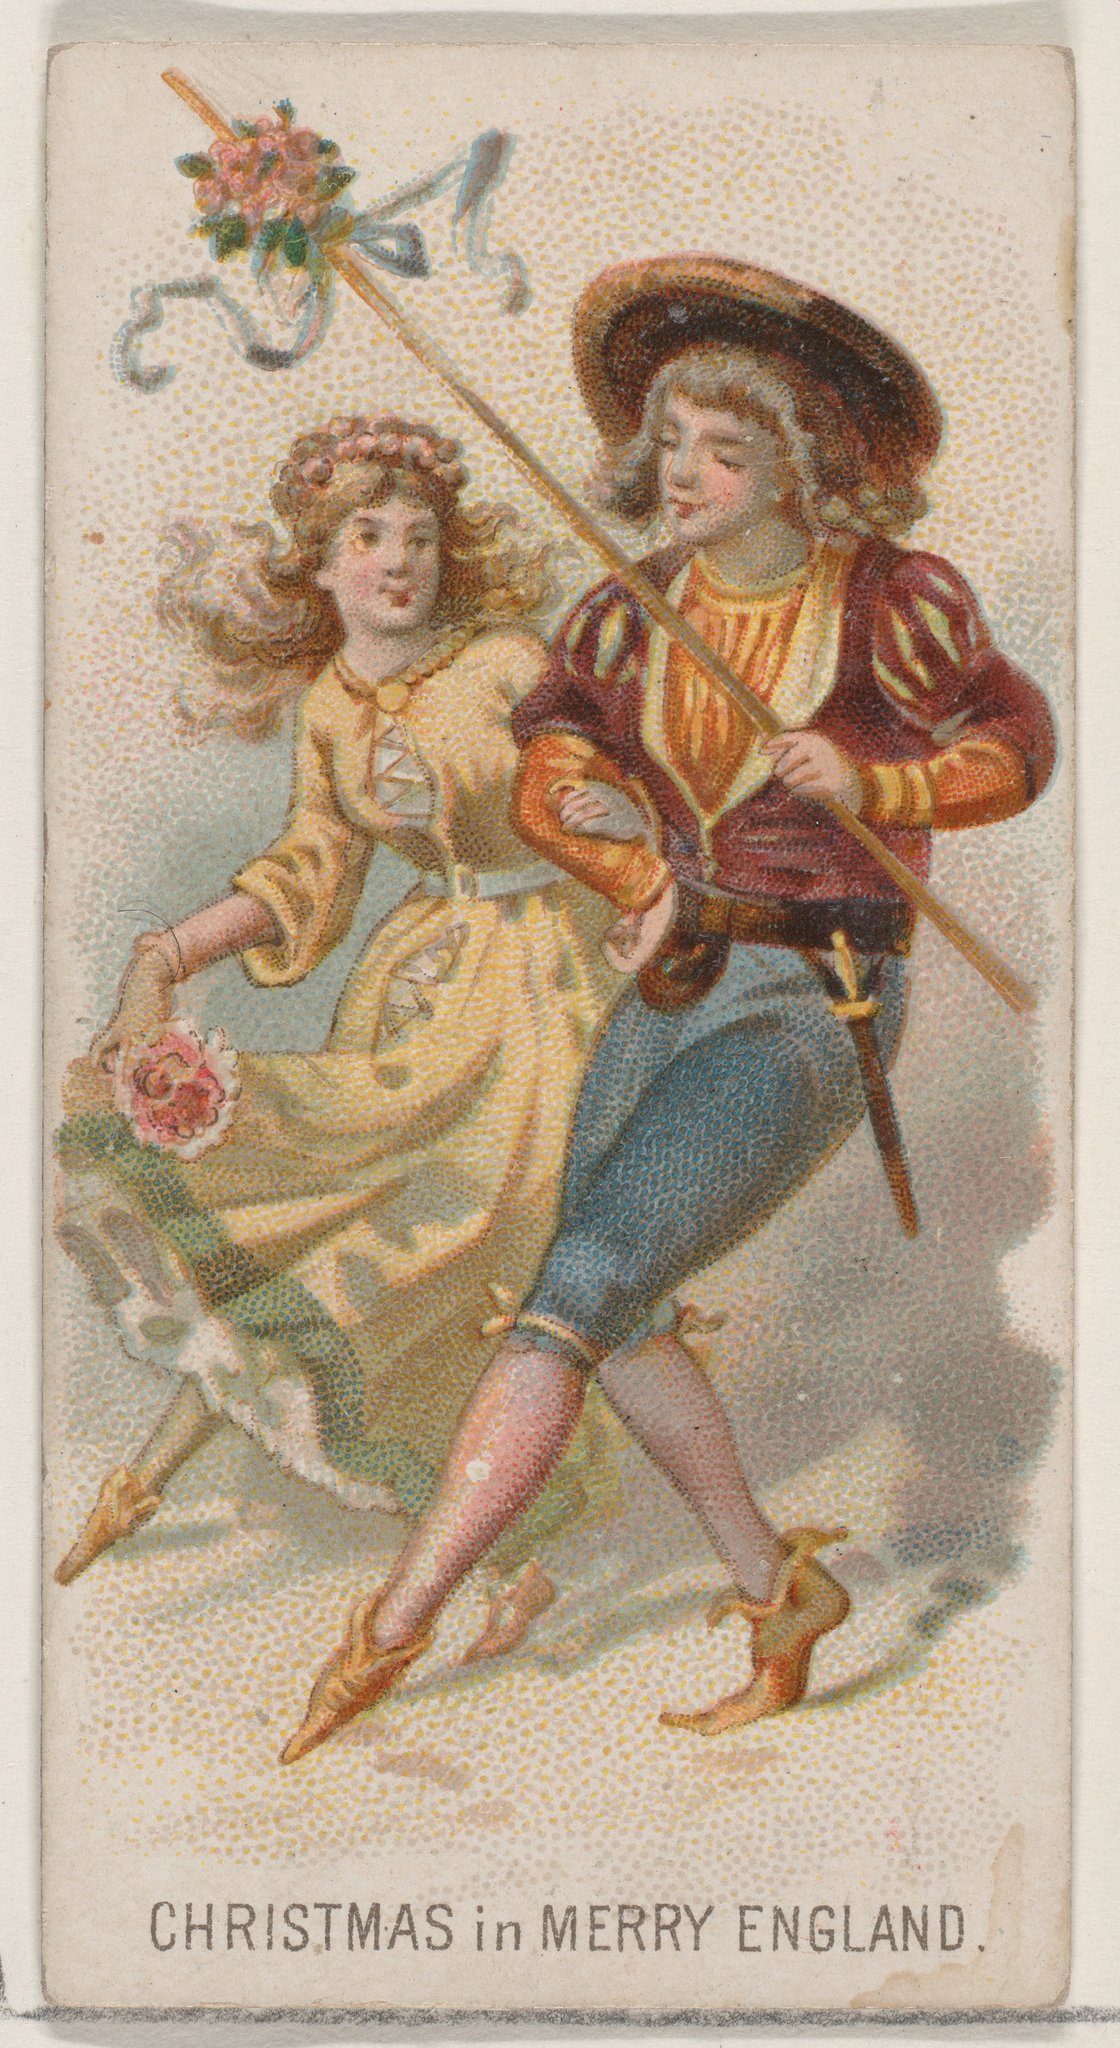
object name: print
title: Christmas in Merry England, from the Holidays series (N80) for Duke brand cigarettes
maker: w. duke, sons & co.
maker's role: publisher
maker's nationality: american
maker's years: 1870-1920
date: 1890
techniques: color lithograph